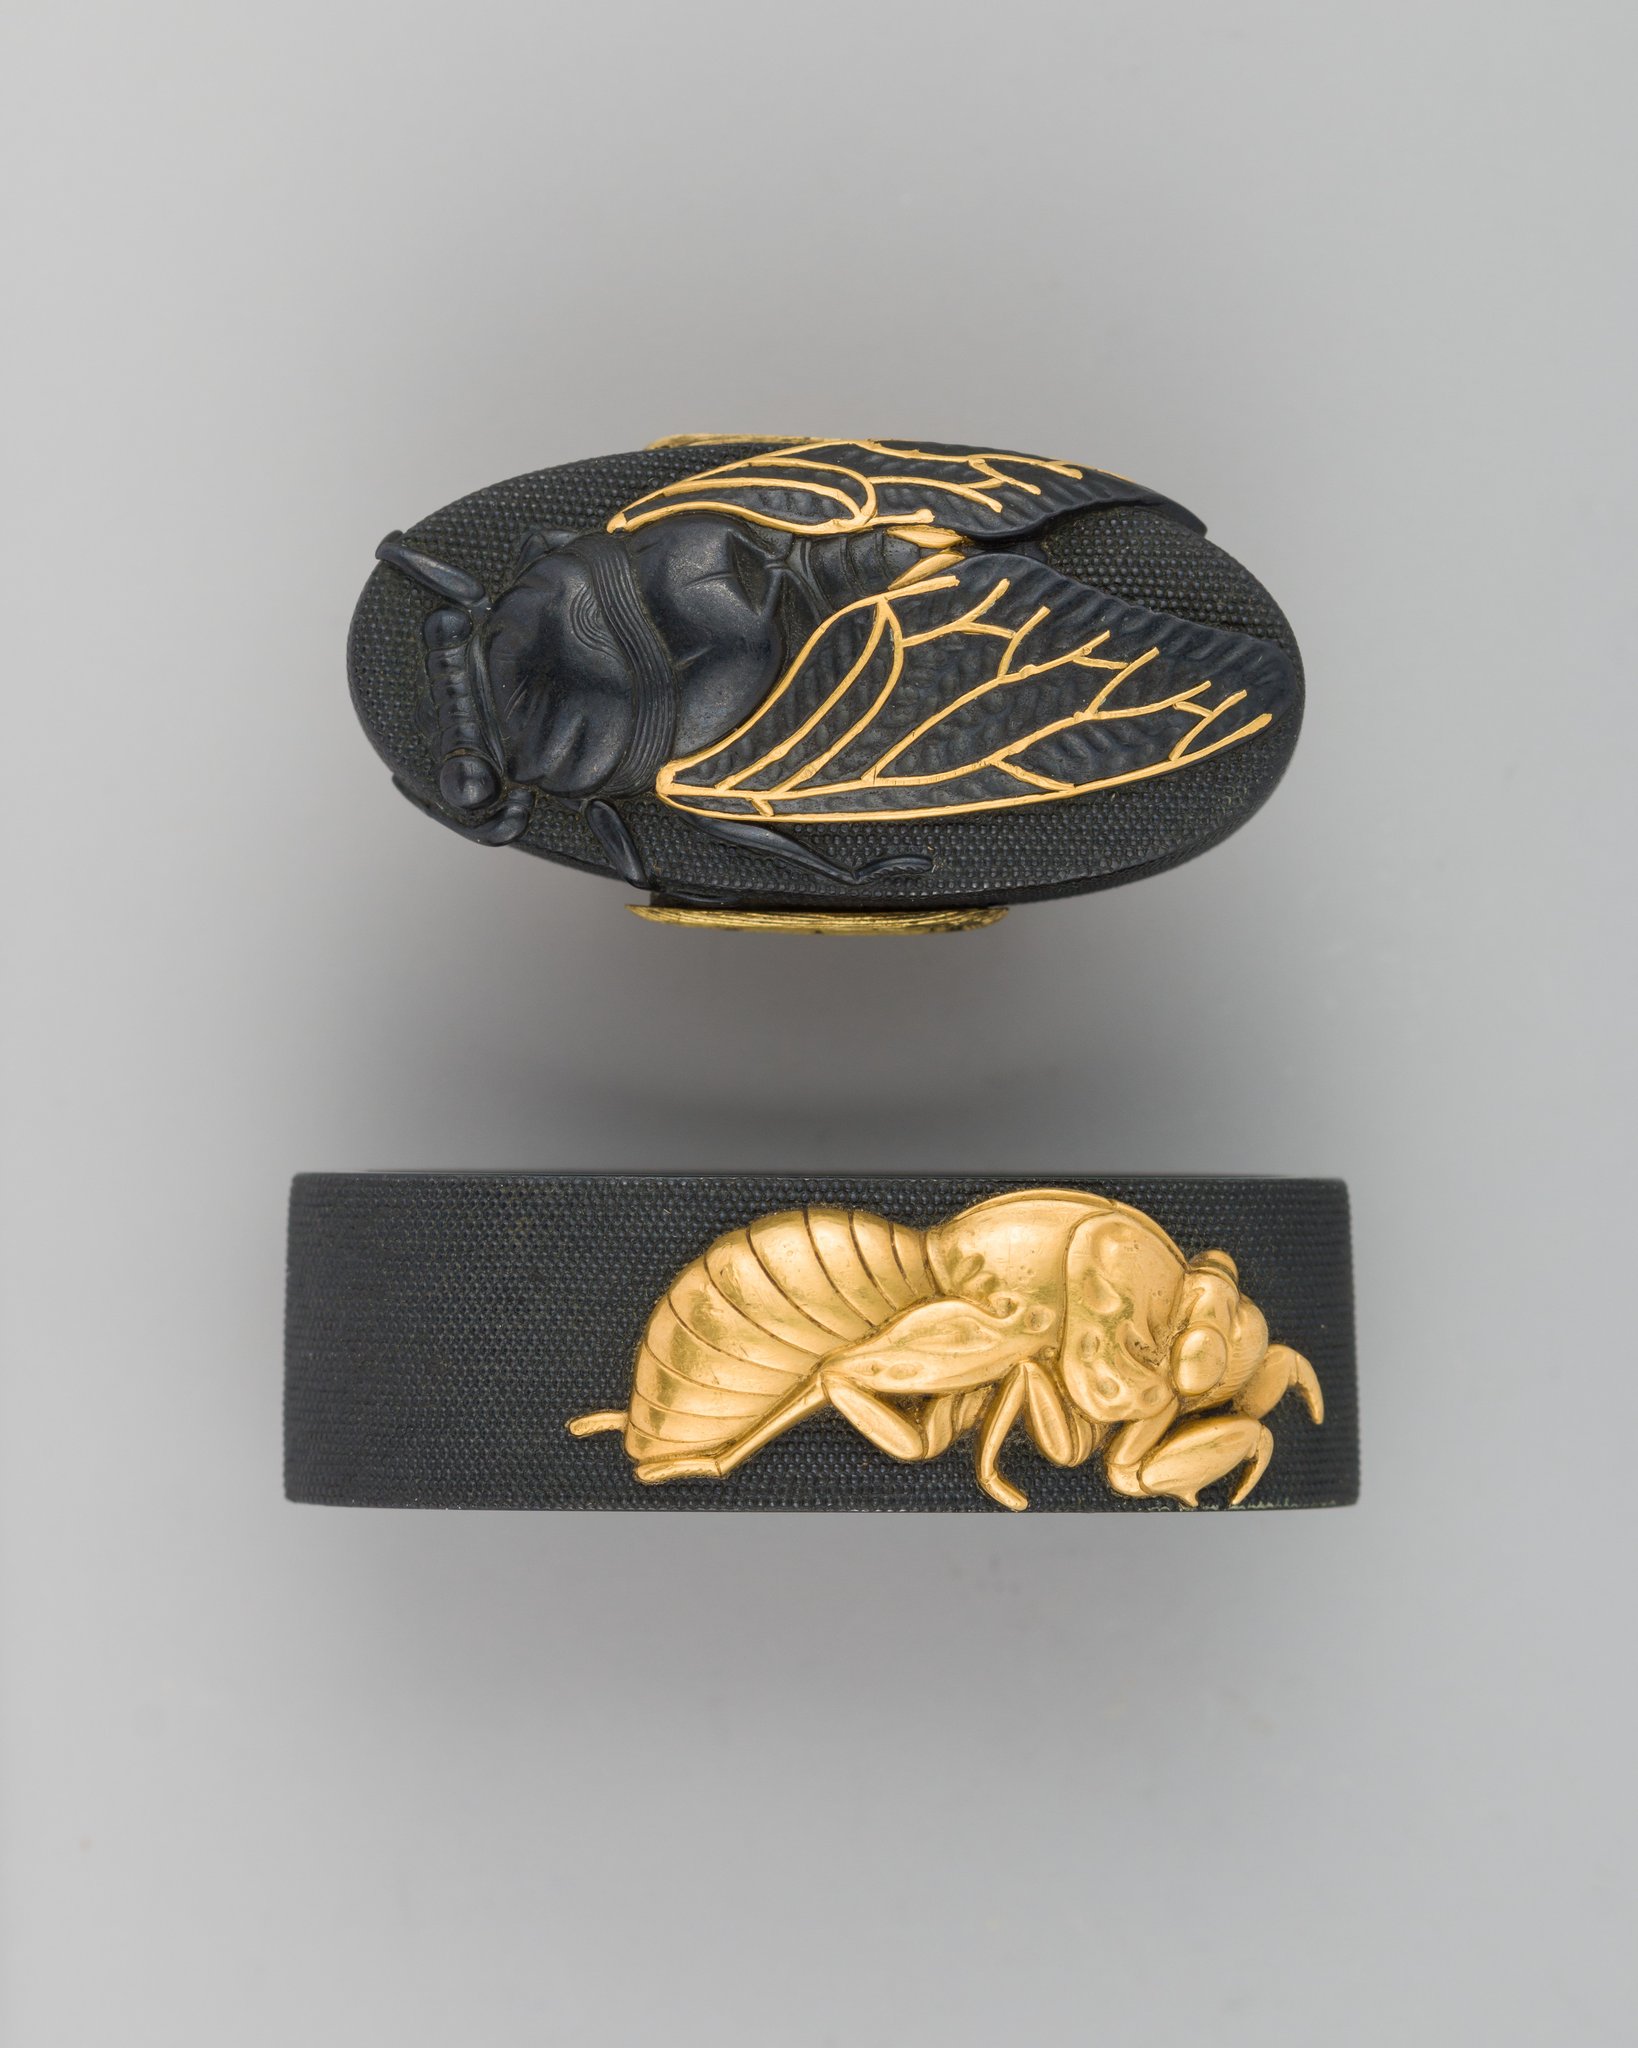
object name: sword hilt collar and pommel fuchigashira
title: Sword-Hilt Collar and Pommel (Fuchigashira)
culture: japanese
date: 1767-1800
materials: gold alloy, gold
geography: japan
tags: insects